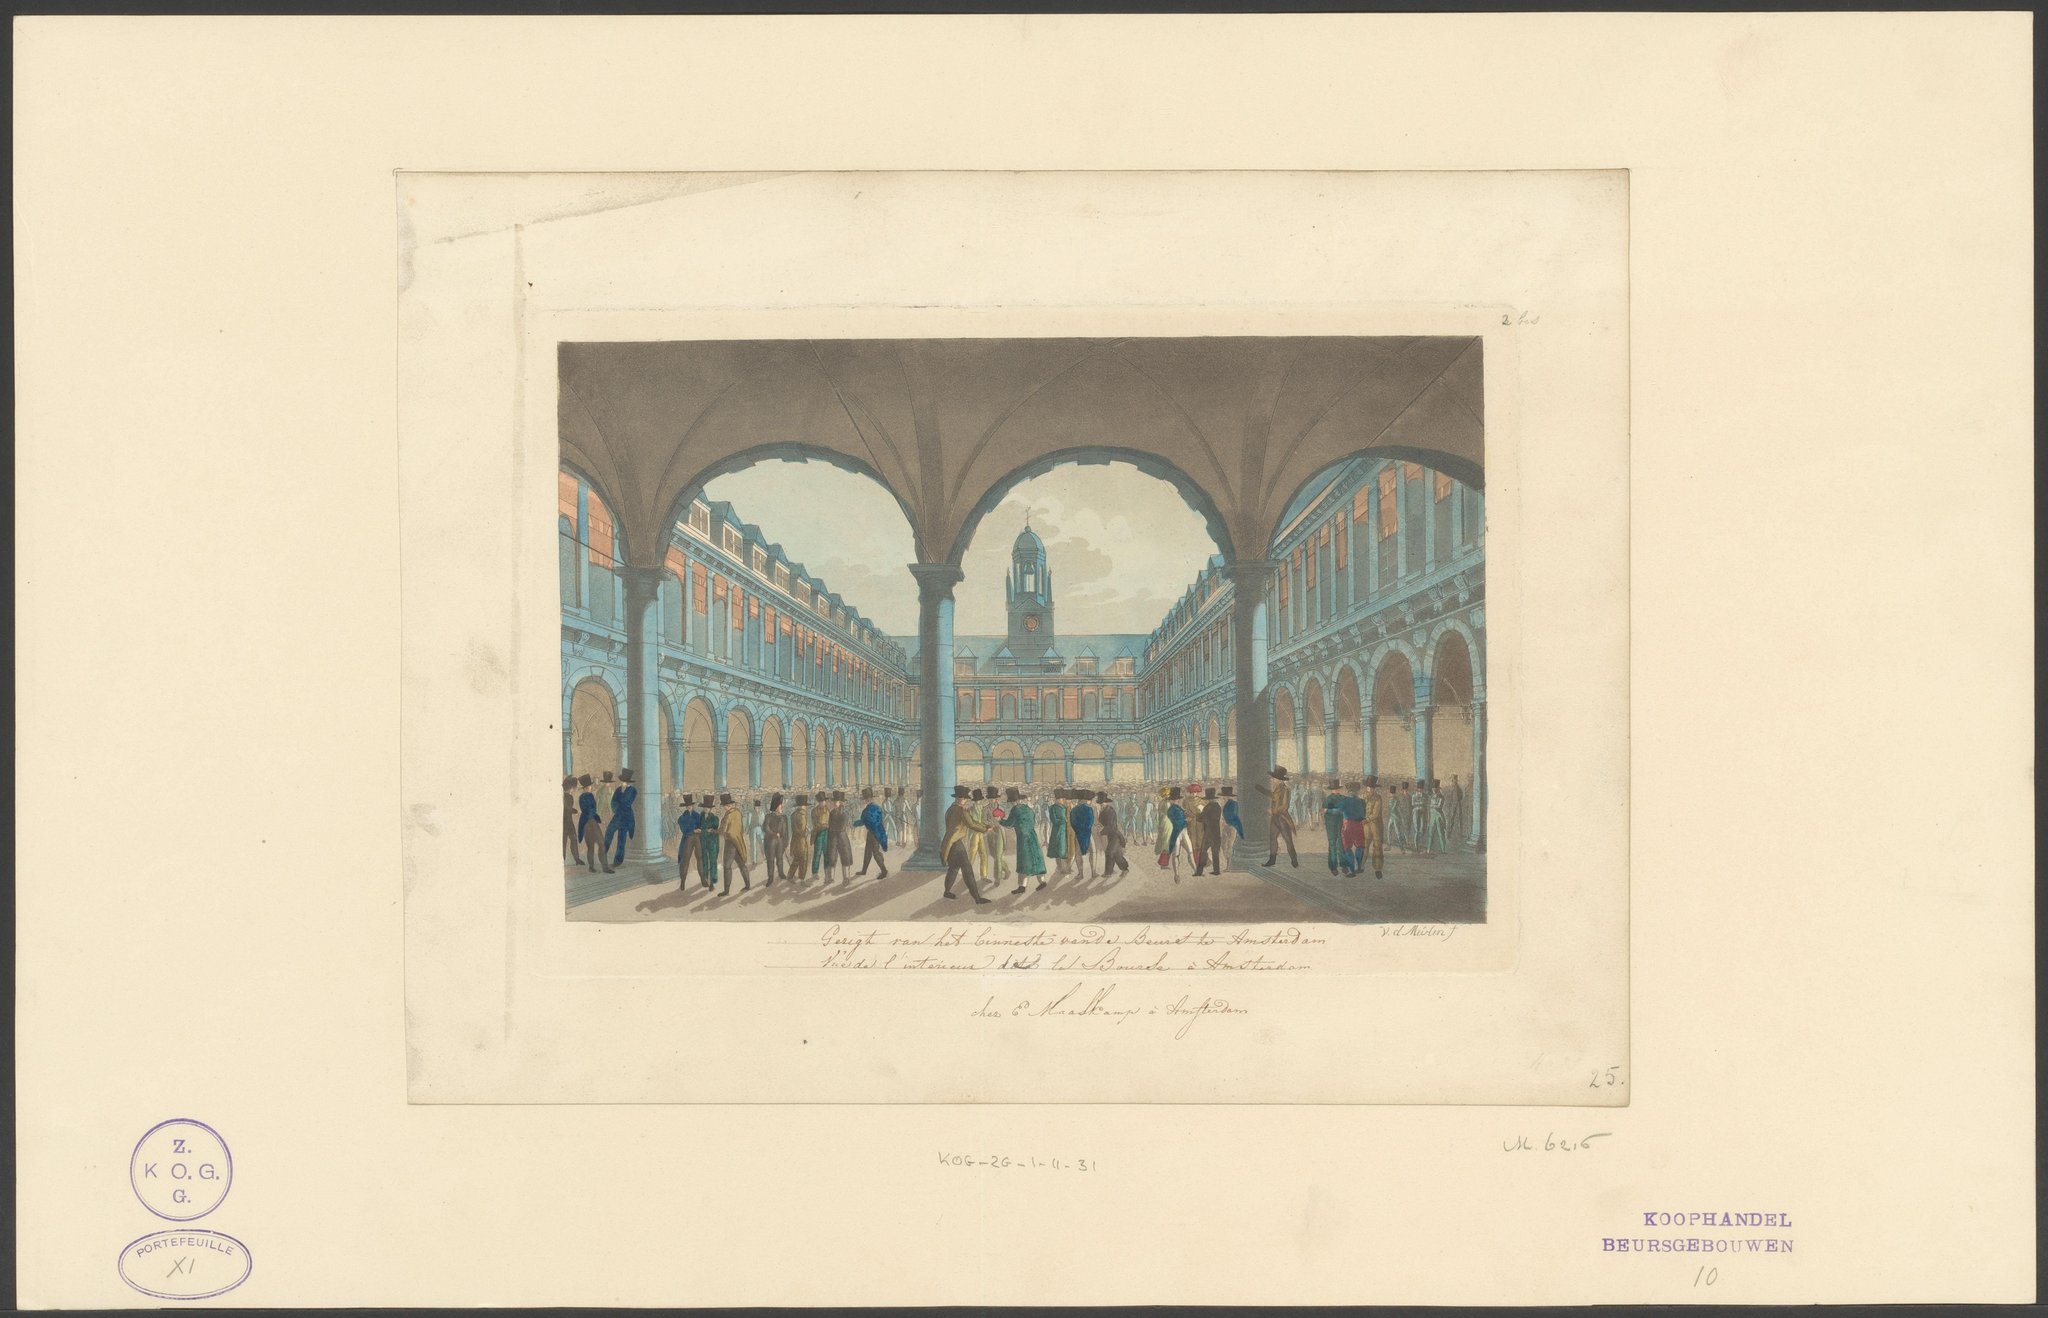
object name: print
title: Gezigt van het binneste van de Beurs te Amsterdam / Vue de l'interieur de la Bourse à Amsterdam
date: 1838-1879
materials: paper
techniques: aquatint, etching, hand coloring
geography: amsterdam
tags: stock exchange, stock-market, street (+ city(-scape) with figures, staffage), amsterdam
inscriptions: inscription: ‘titel en naam uitgever’, collector's mark: Lugt 1641, stamp, stamp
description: Onderwerpsrubrieken binnen de Atlas Zeden en Gewoonten: Handel, nijverheid en verkeer, Koophandel, Beursgebouwen.